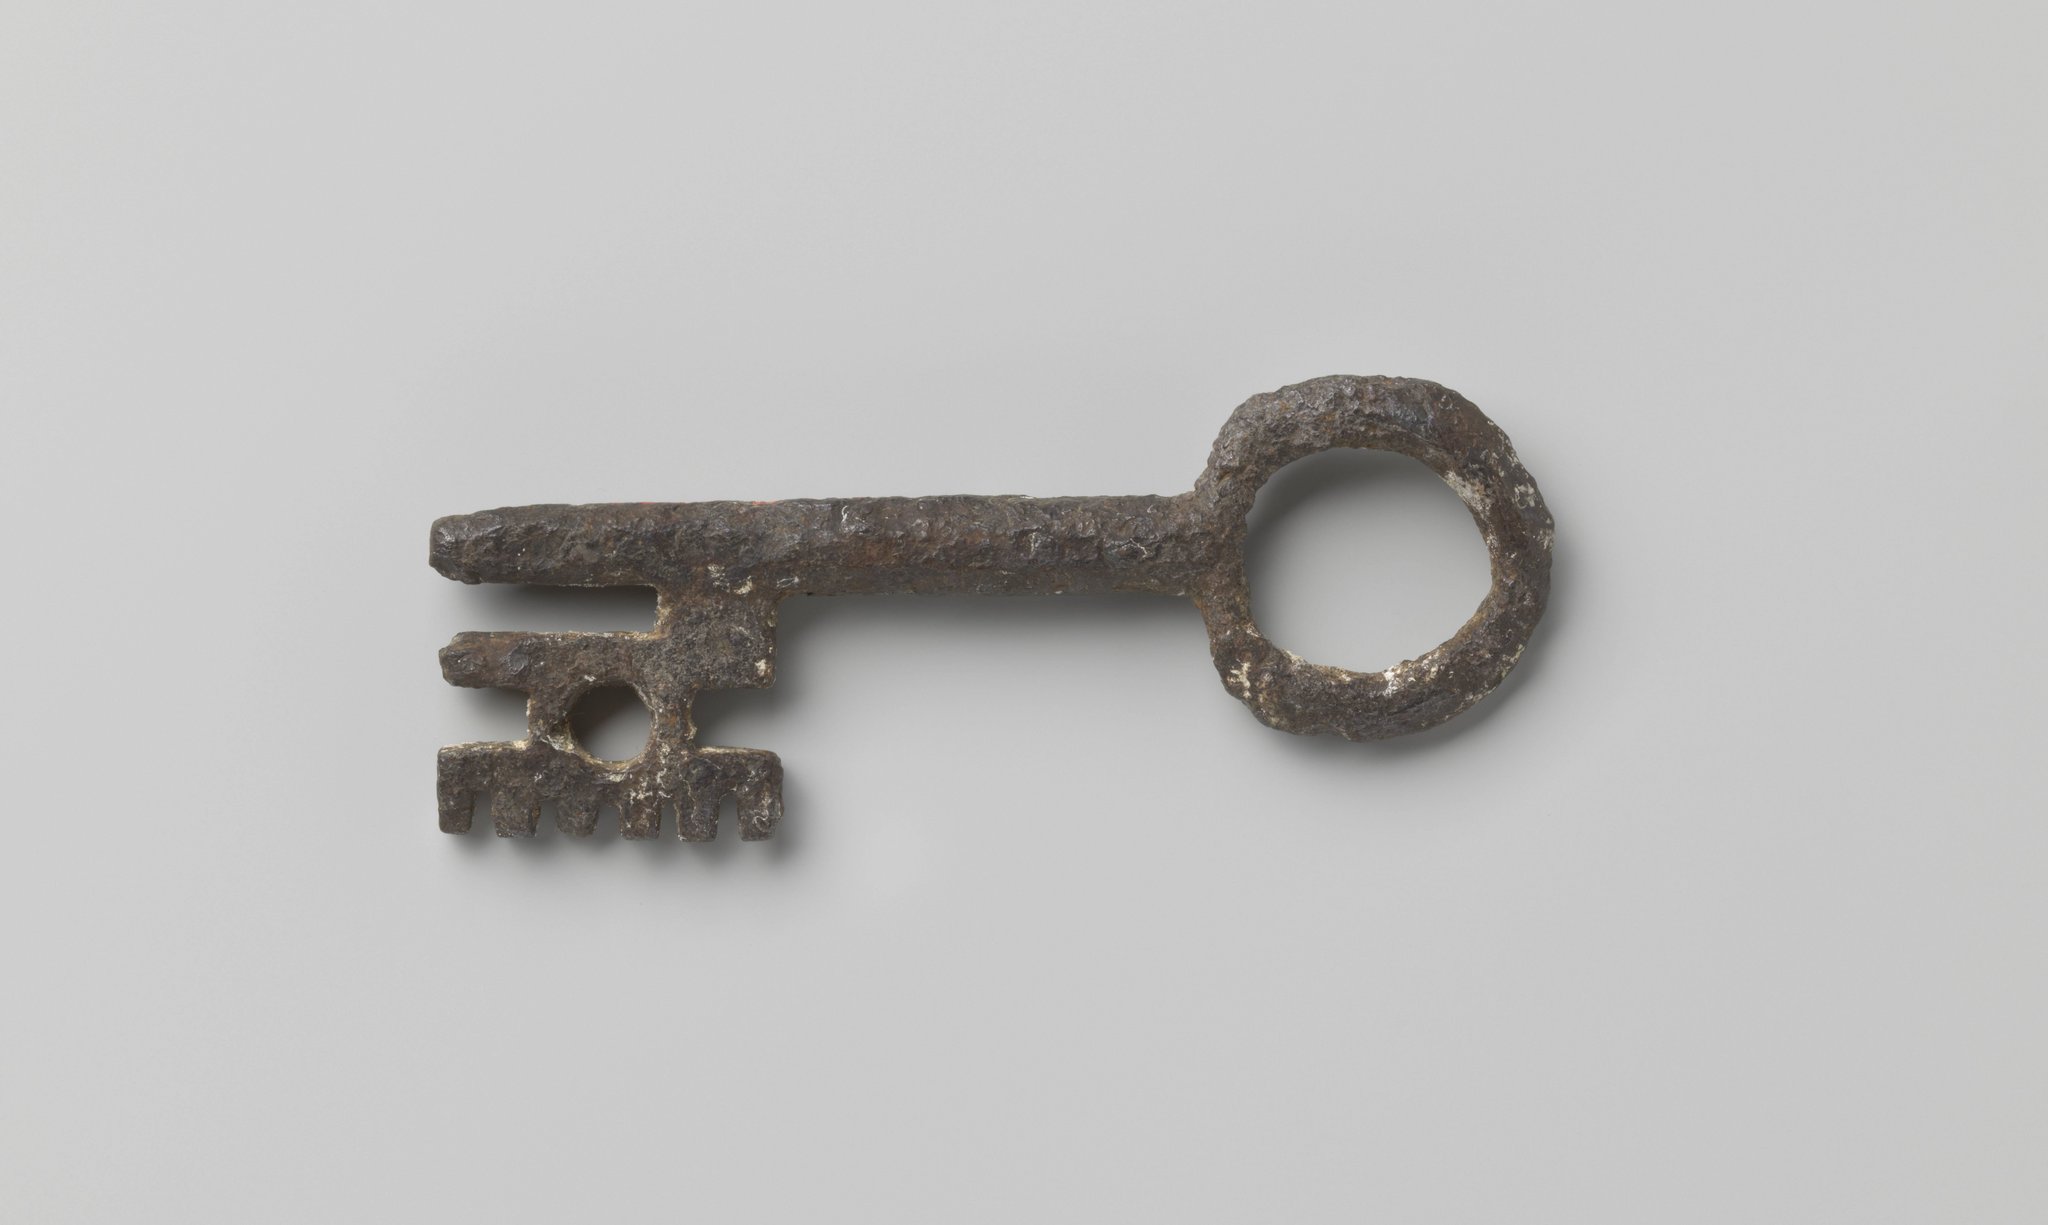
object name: key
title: Sleutel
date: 1400-1500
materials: iron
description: Sleutel met cirkelvormig oog en vierkante baard die een rond gat vertoont en kamvormig eindigd.